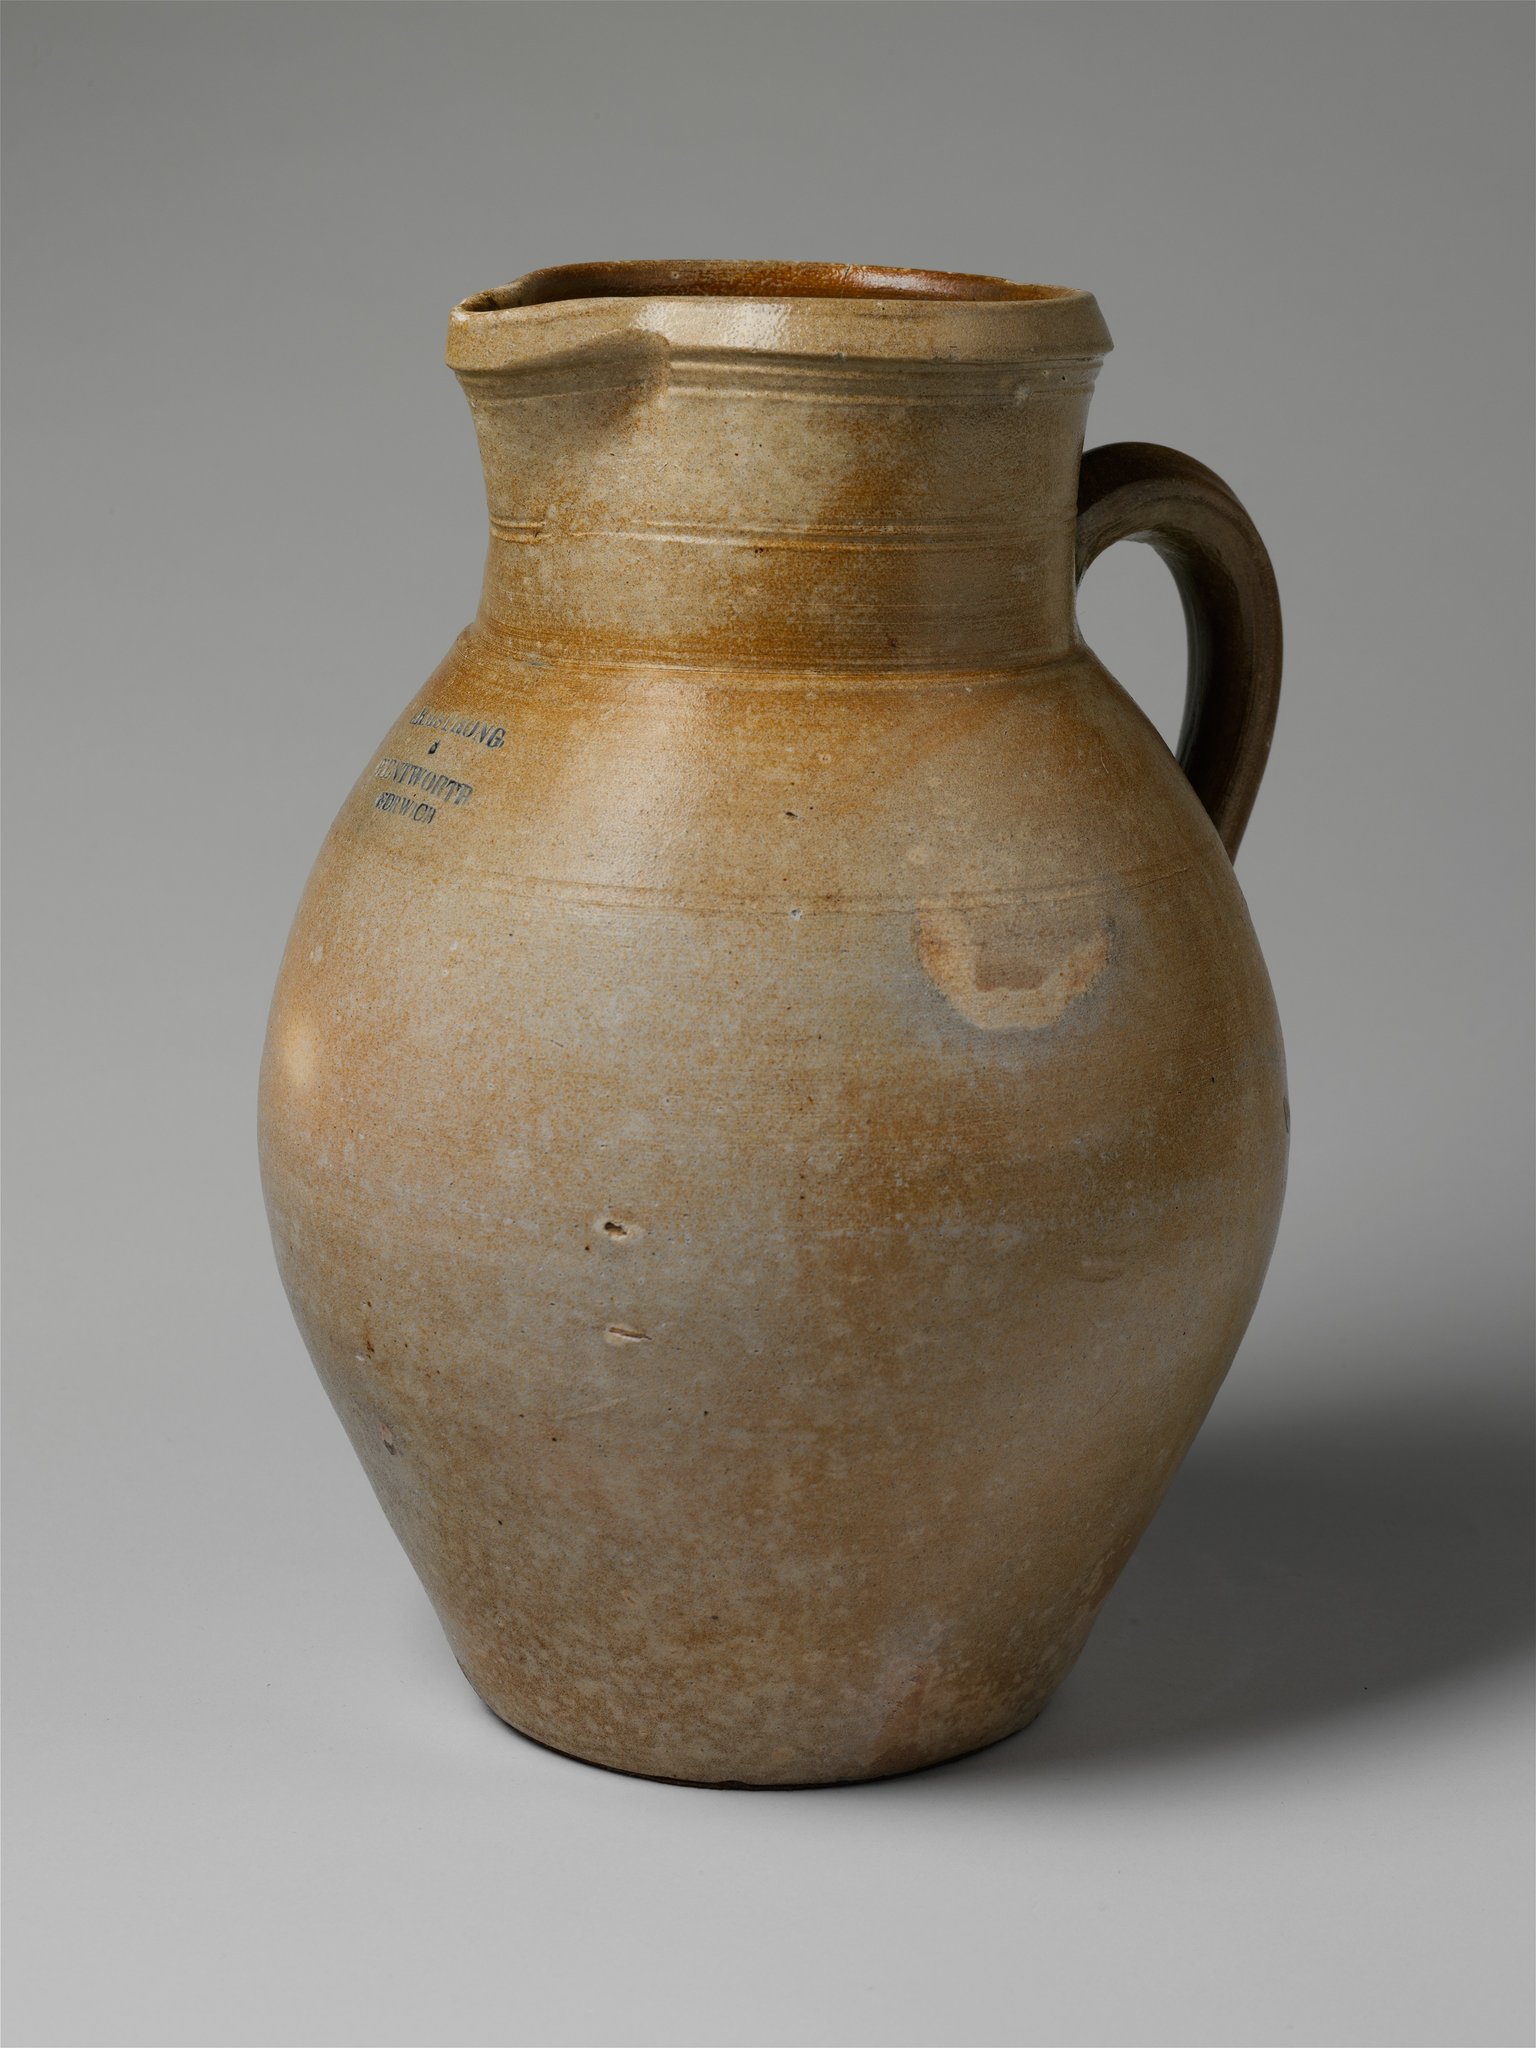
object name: pitcher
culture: american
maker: peleg armstrong and erastus wentworth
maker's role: maker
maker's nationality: american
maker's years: 1814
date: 1814-1828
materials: stoneware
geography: united states